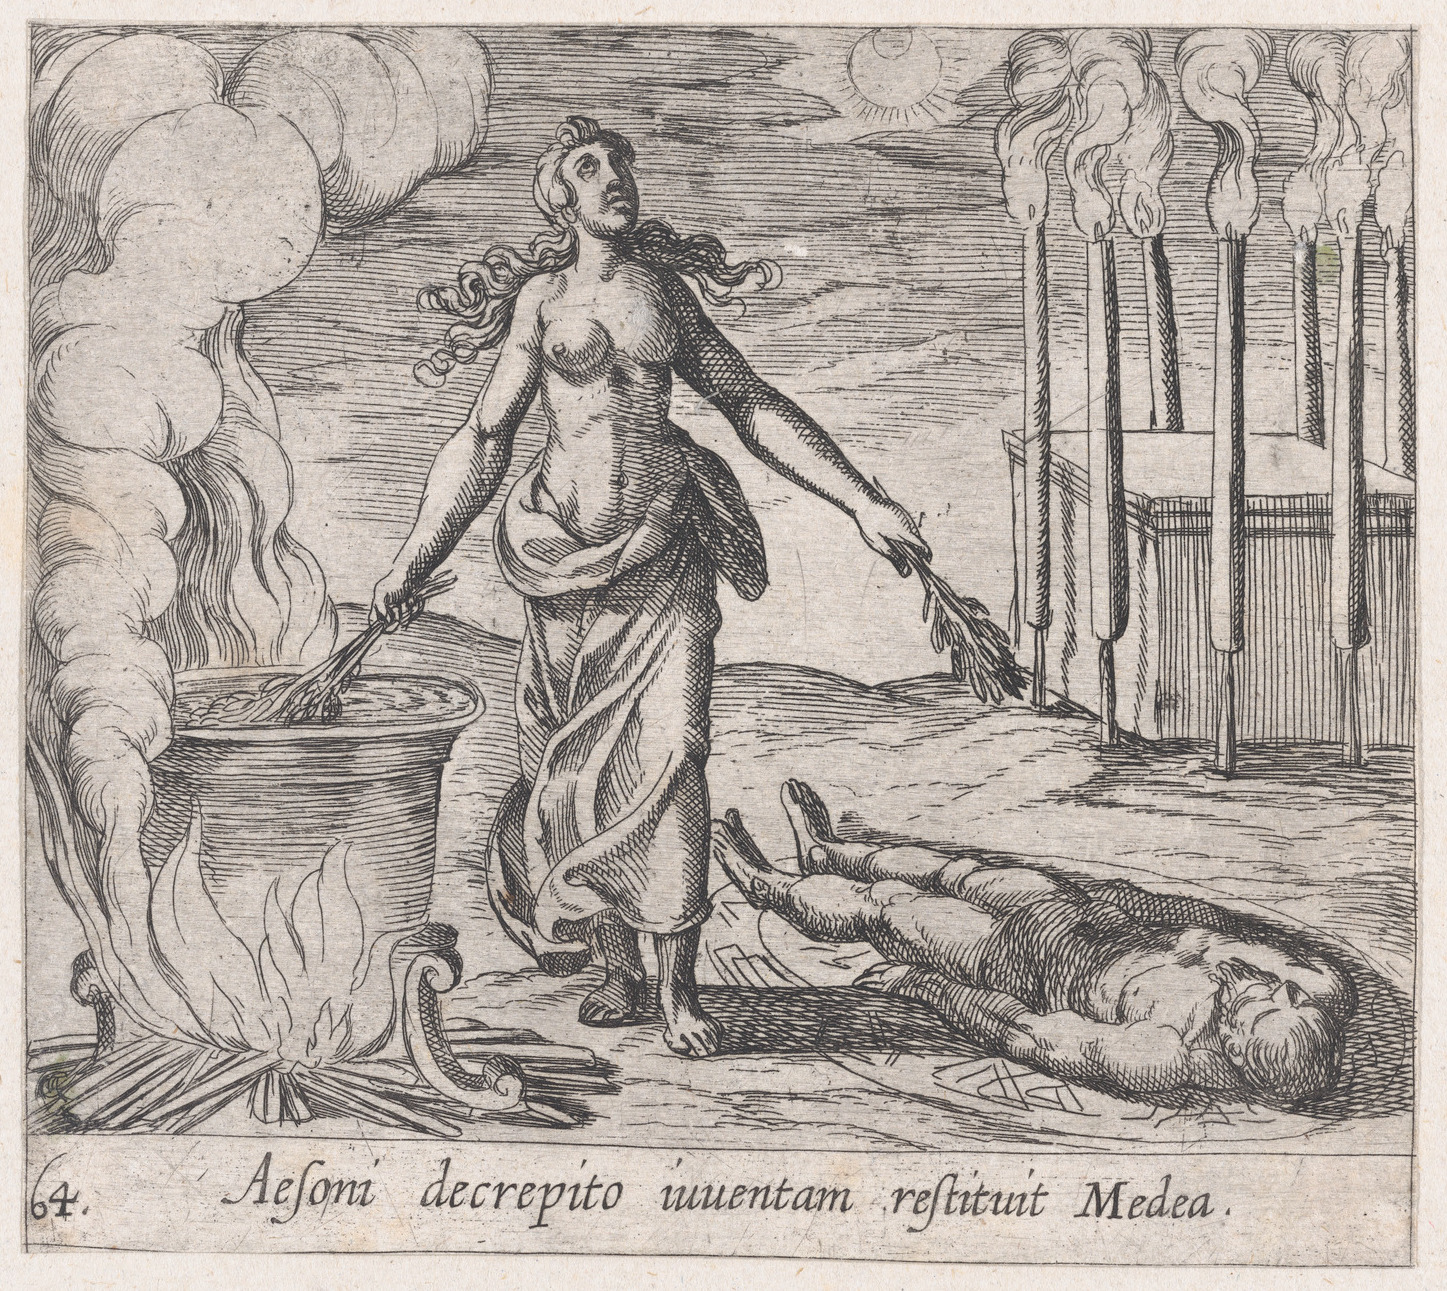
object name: print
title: Plate 64: Medea Restoring Aeson's Youth (Aesoni decrepito iuventam restituit Medea), from Ovid's 'Metamorphoses'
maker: antonio tempesta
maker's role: artist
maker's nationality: italian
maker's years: 1555-1630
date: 1606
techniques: etching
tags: men,medea,fire